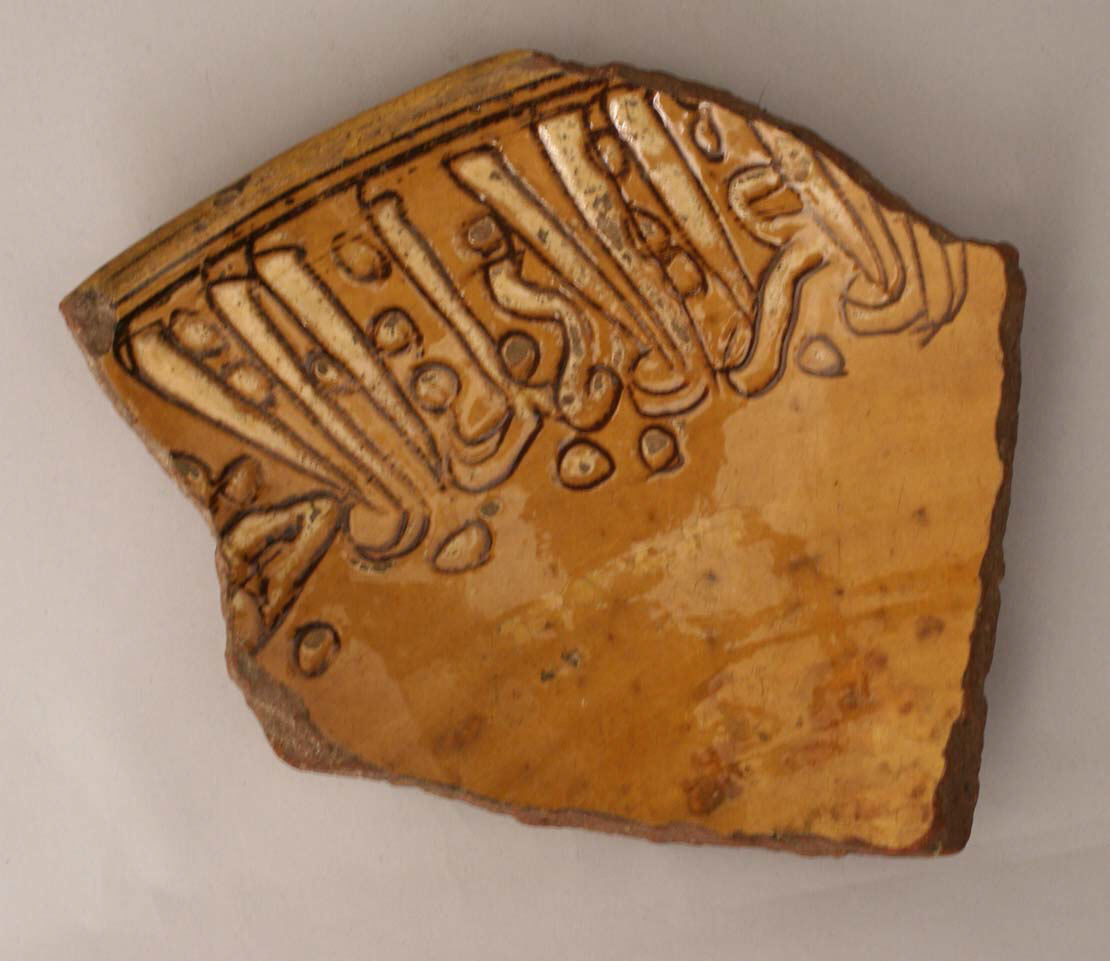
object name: fragment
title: Ceramic Fragment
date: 1301-1500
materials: earthenware, glaze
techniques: coloring, incising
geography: egypt